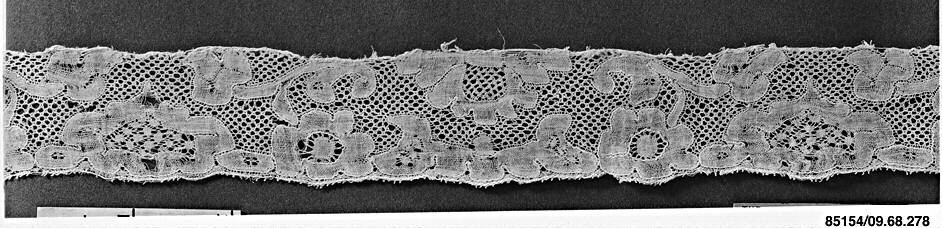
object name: strip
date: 1701-1800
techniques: lace